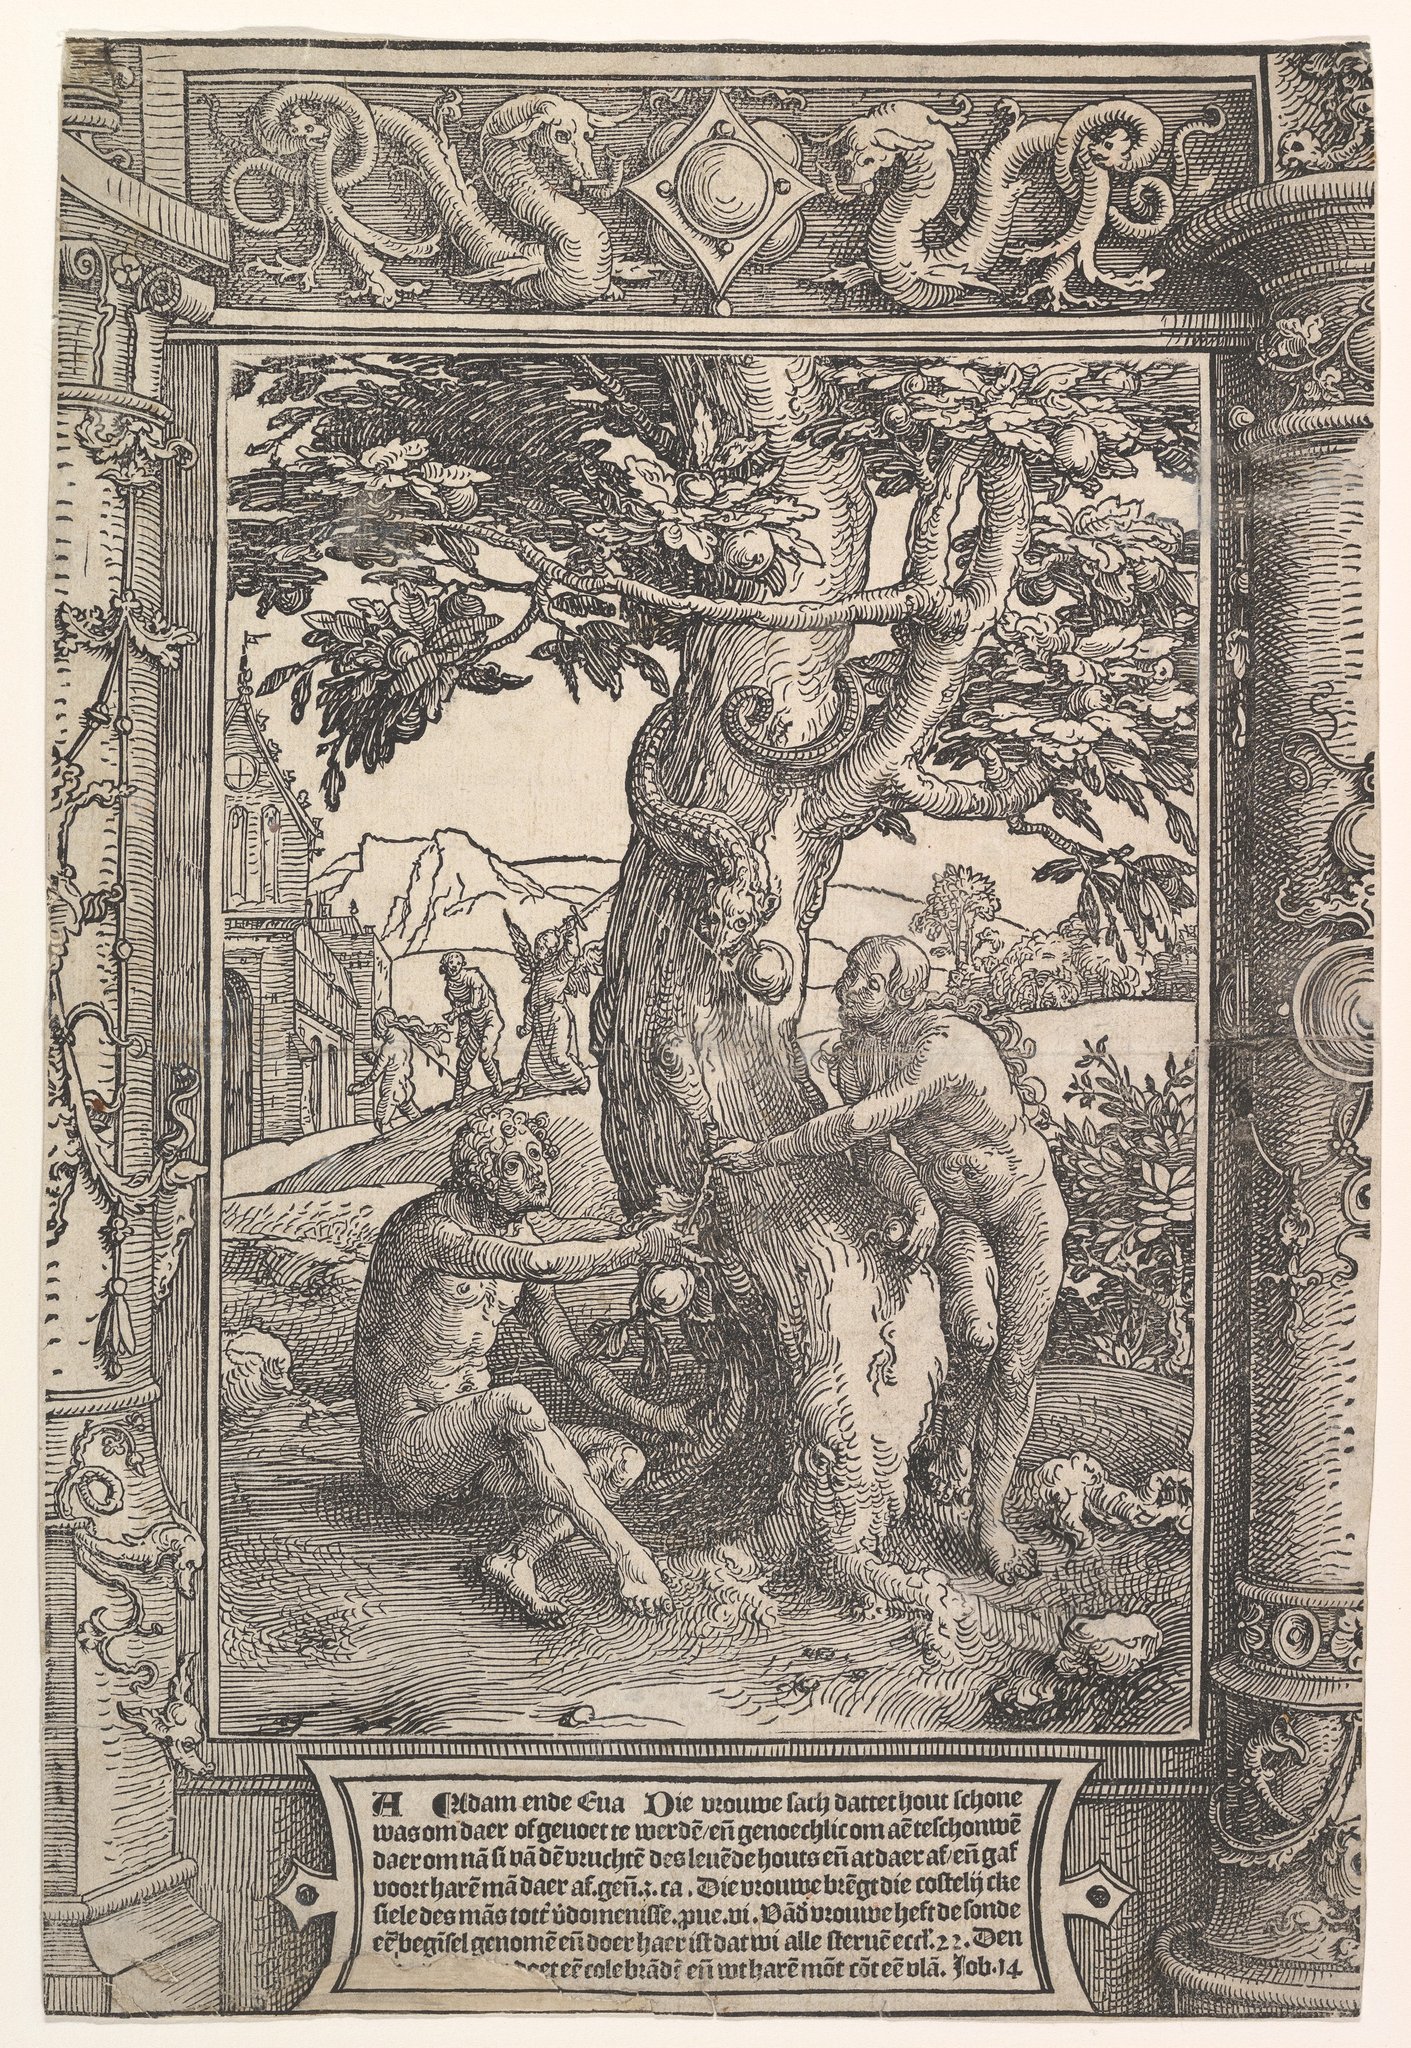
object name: print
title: The Fall of Man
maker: lucas van leyden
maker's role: artist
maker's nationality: netherlandish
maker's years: 1494-1533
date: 1517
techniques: woodcut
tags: gardens,snakes,adam,eve